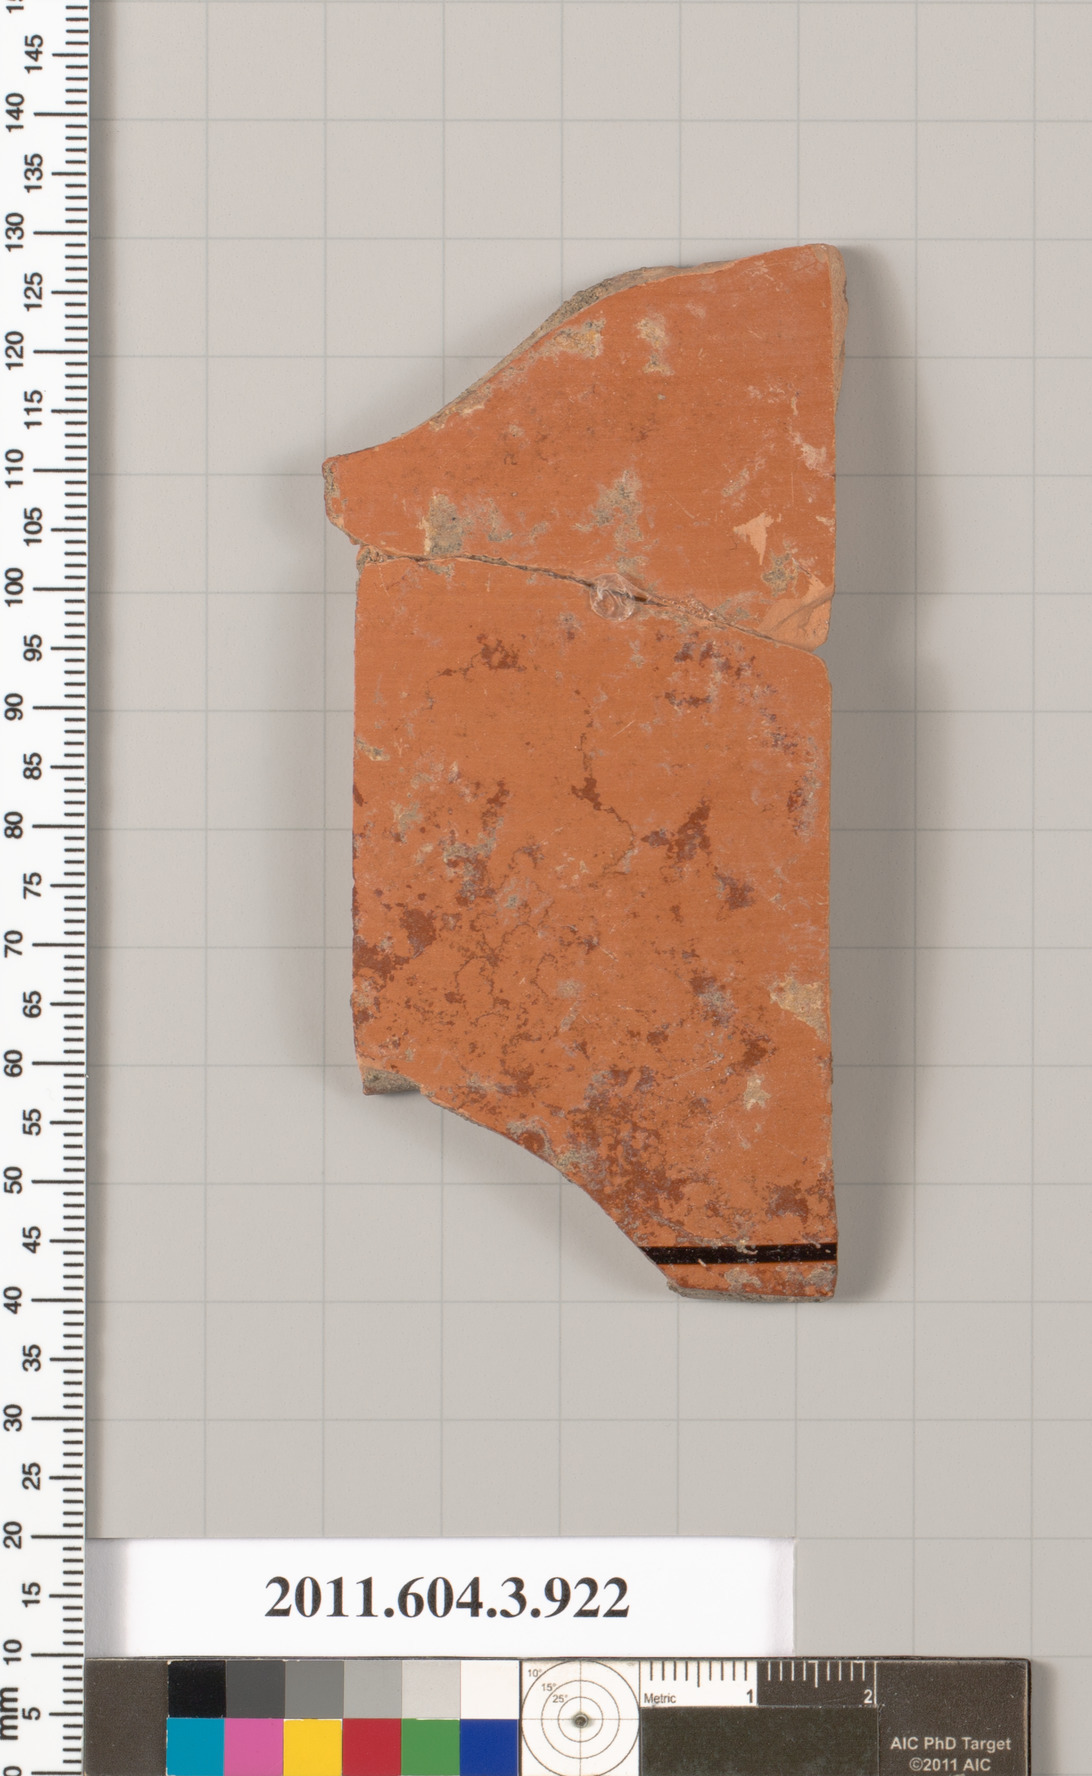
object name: lekythos fragment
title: Terracotta fragment of a lekythos (oil flask)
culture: greek, attic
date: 600-401 BCE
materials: terracotta